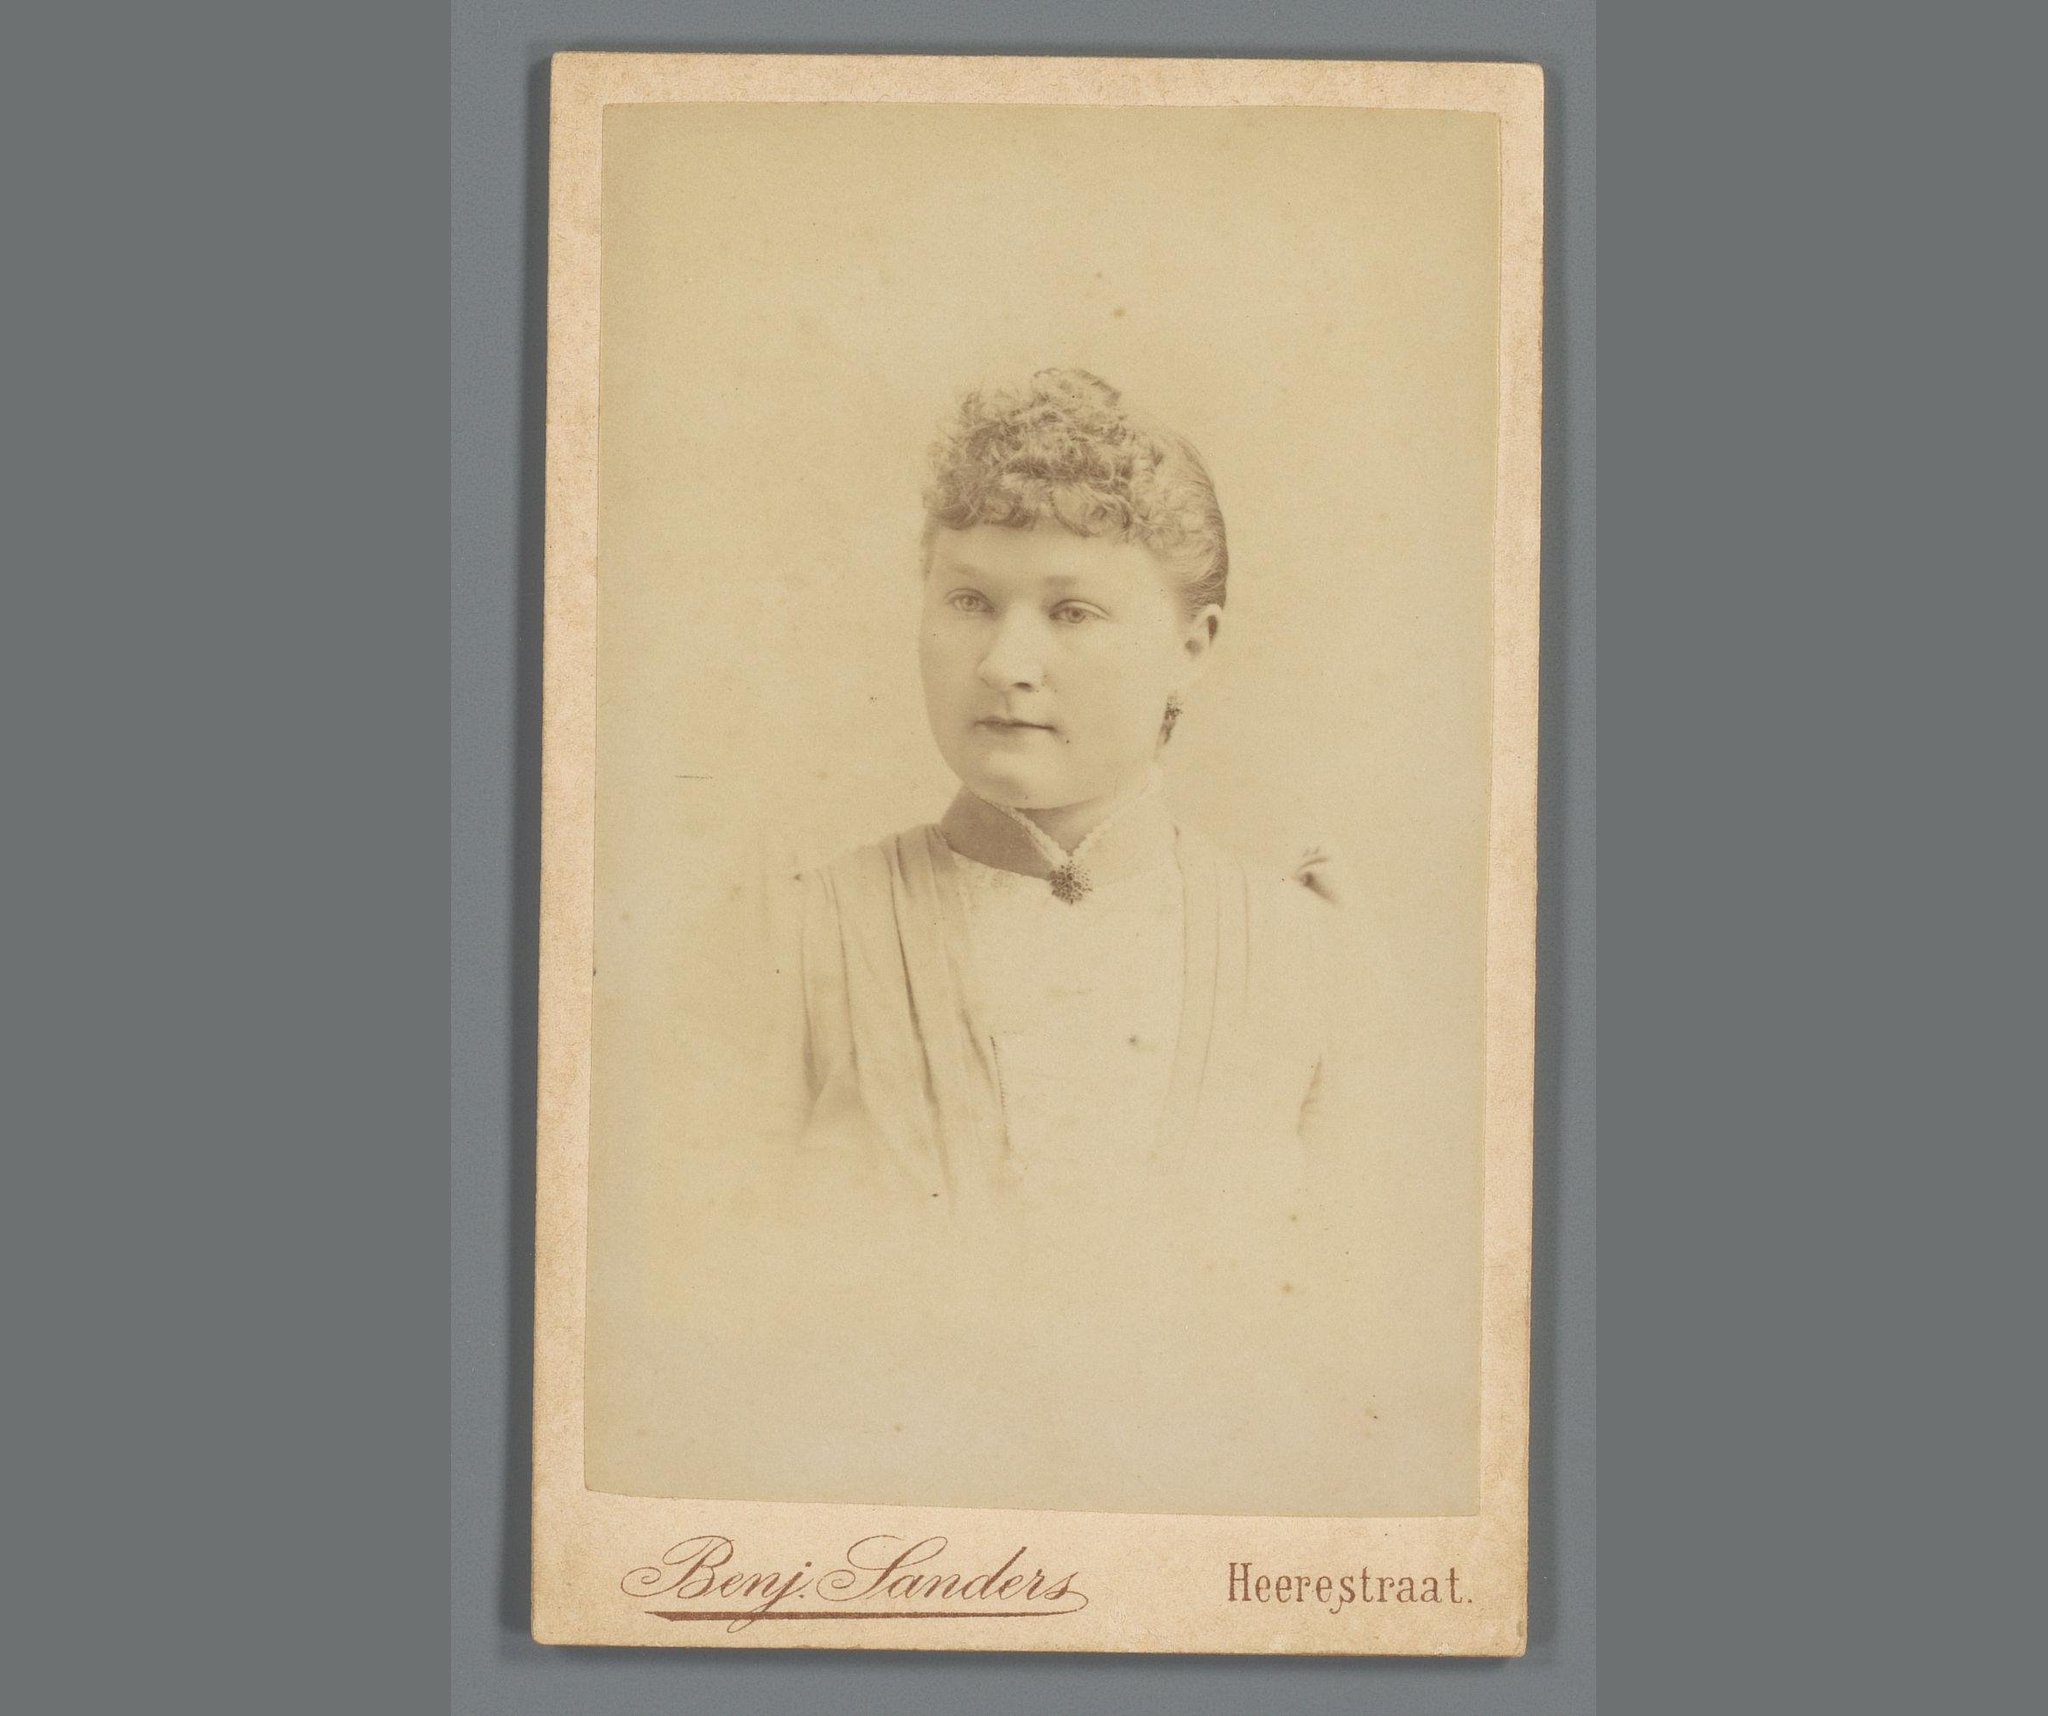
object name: photograph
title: Portret van Trudi Meyer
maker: benjamin sanders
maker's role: fotograaf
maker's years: 1841-1889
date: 1880-1889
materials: cardboard, paper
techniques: albumen print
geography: groningen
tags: historical persons - bb - woman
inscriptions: inscription: ‘Trudi Meyer/ Moeder Knol’, inscription: ‘BENJ. SANDERS/ GRONINGEN/ Heerestraat 306./ Vergrootingen worden naar ieder portret vervaardigd.’